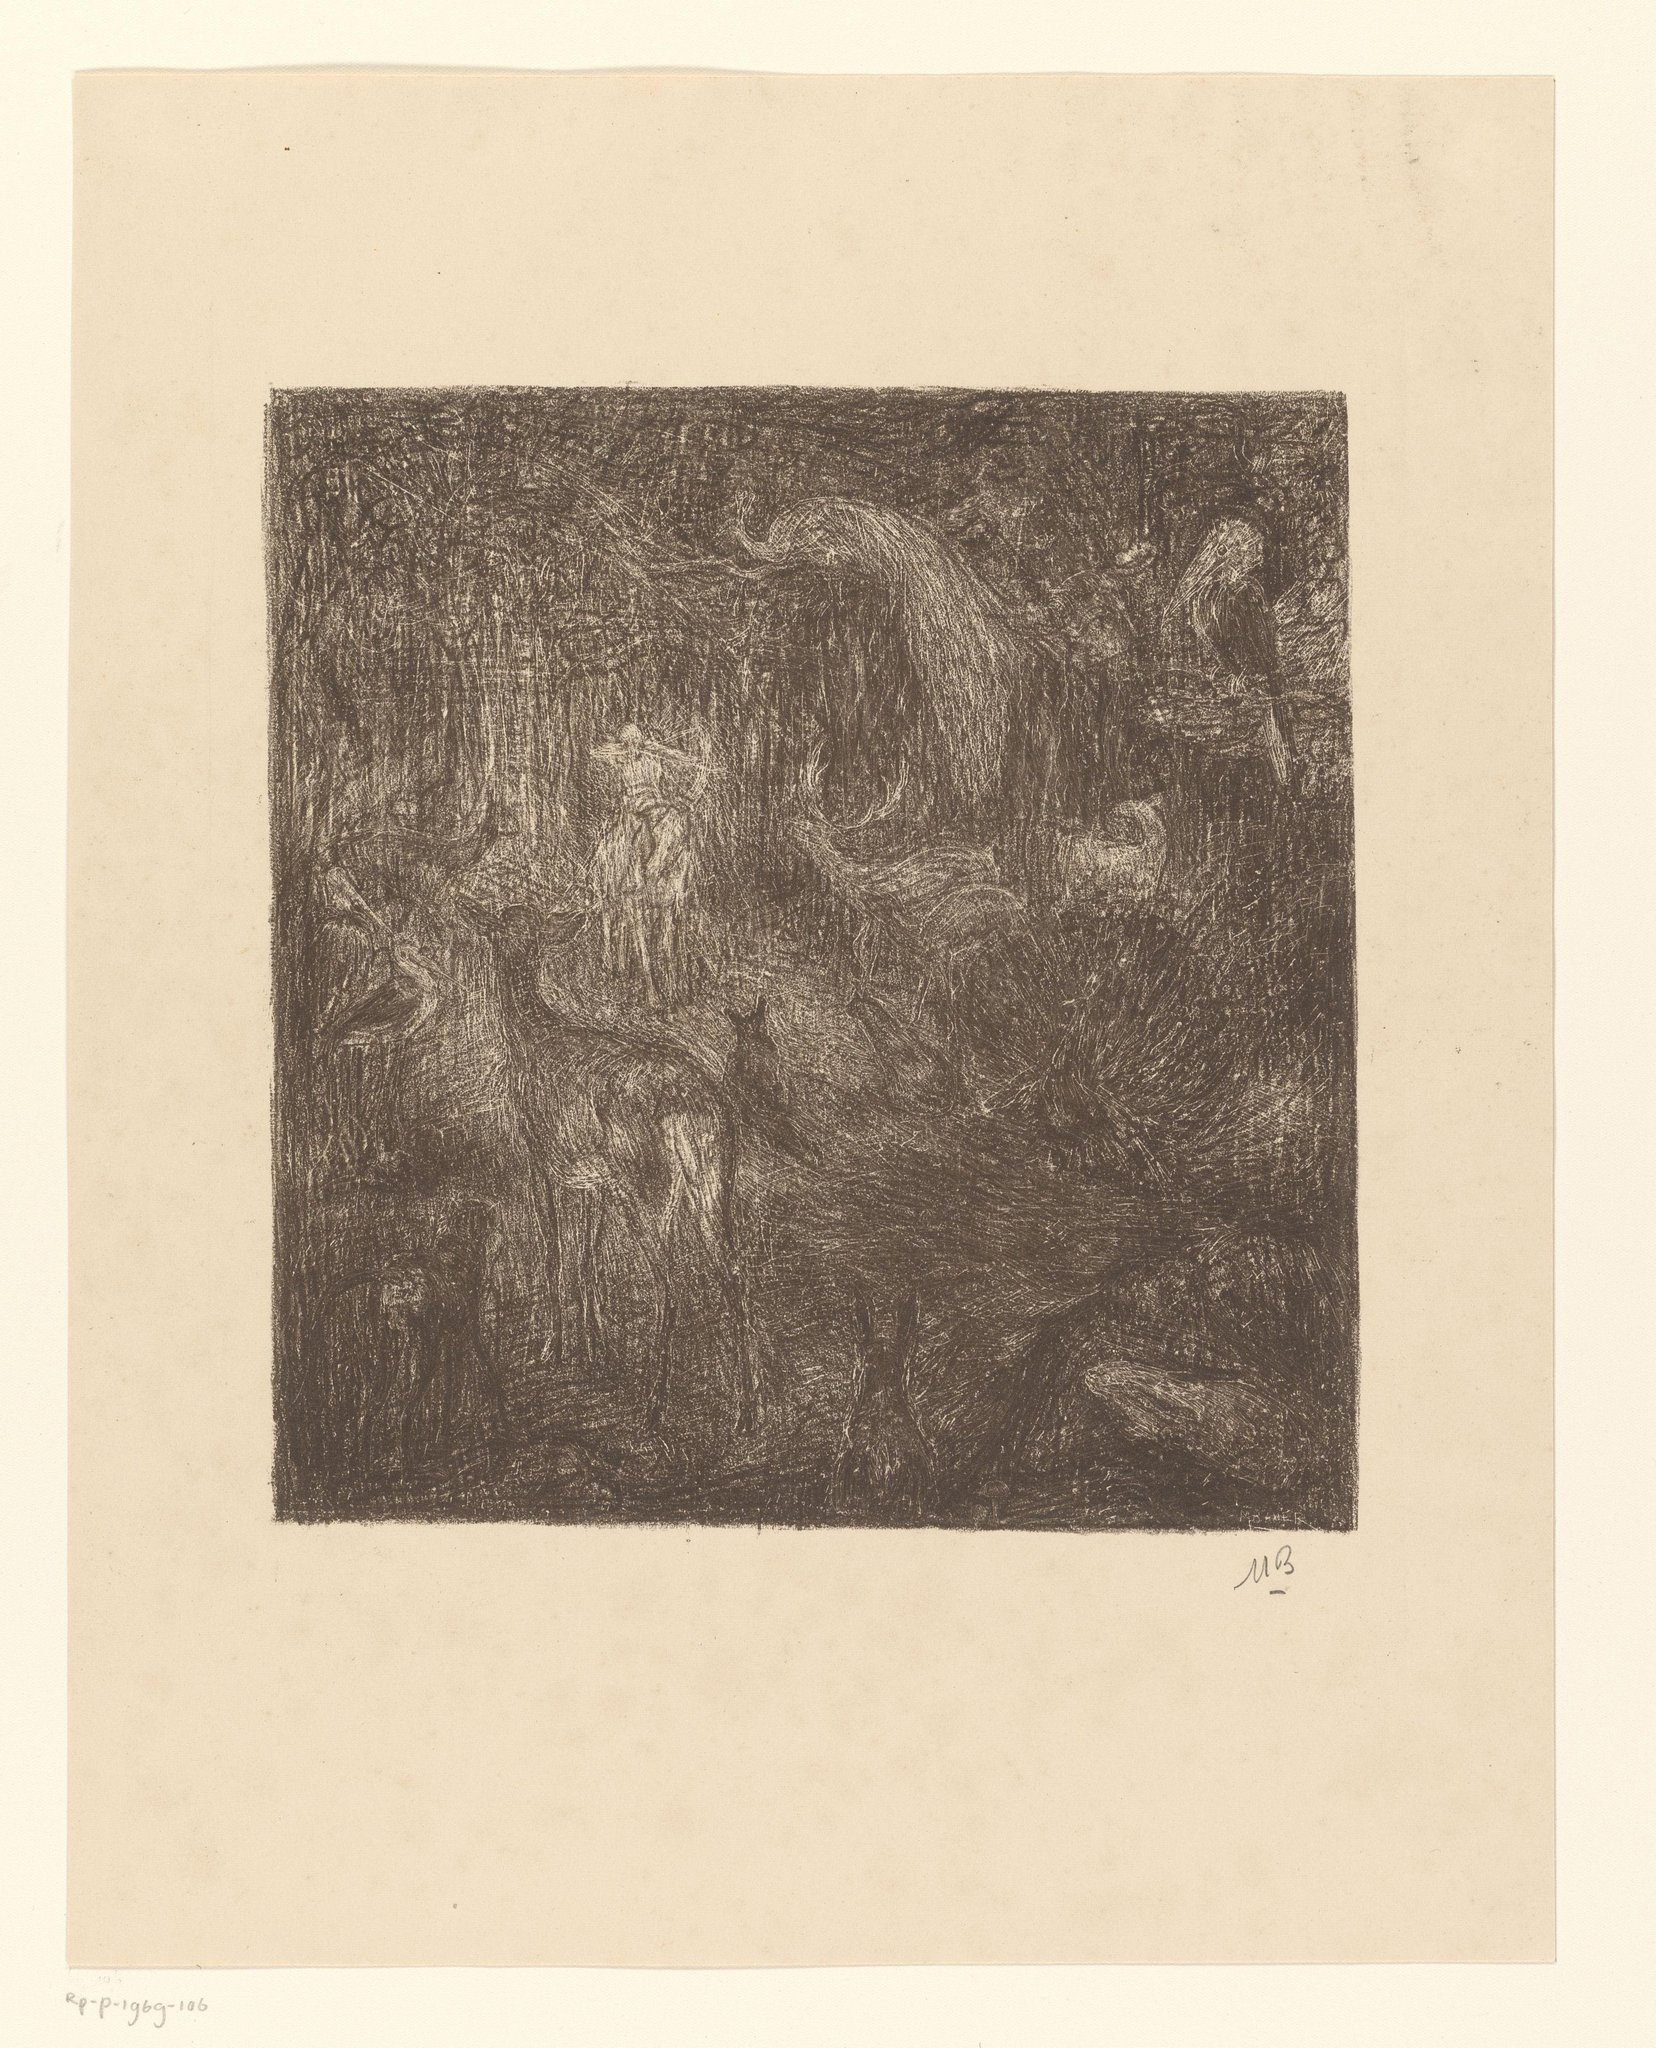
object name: print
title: Elles tournaient autour de lui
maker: marius bauer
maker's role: draughtsman, print maker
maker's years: 1867-1932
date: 1891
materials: paper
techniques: lithograph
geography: the hague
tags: riding a horse, ass, or mule; rider, horseman, archer's weapons, man killing animal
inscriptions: collector's mark: Lugt 2228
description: Prent bedoeld als illustratie bij het verhaal La Légende de Saint Julien l'Hospitalier van Gustave Flaubert uit het boek: Flaubert, Gustave. Trois Contes. Parijs: G. Charpentier, 1877.